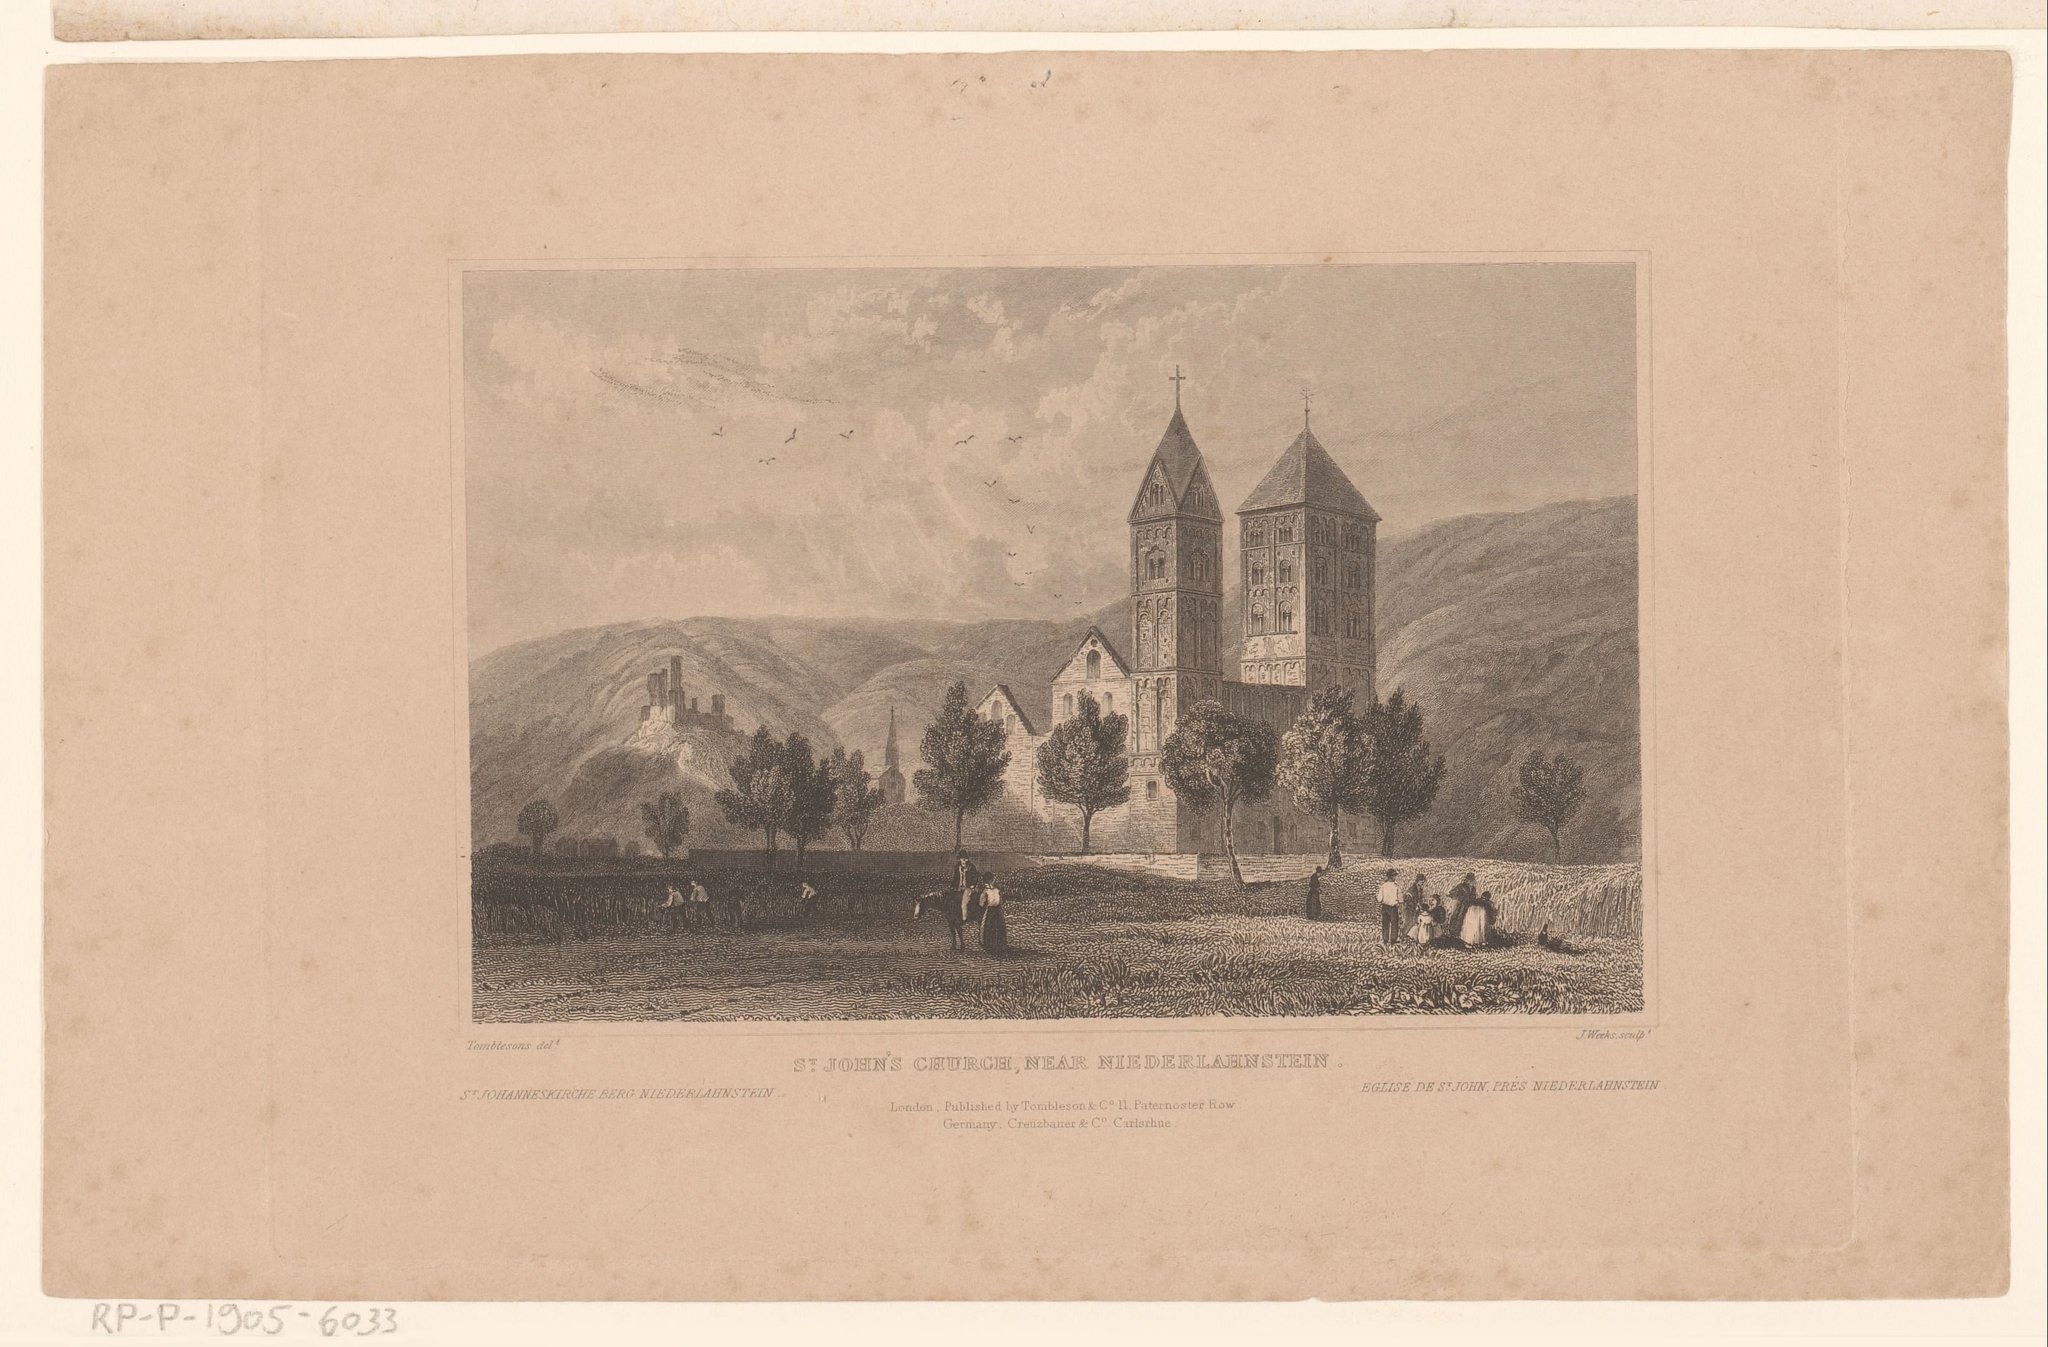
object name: print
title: Gezicht op Neckargemünd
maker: Anonymous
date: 1800-1899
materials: paper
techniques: etching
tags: prospect of village, silhouette of village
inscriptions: collector's mark: Lugt 2228